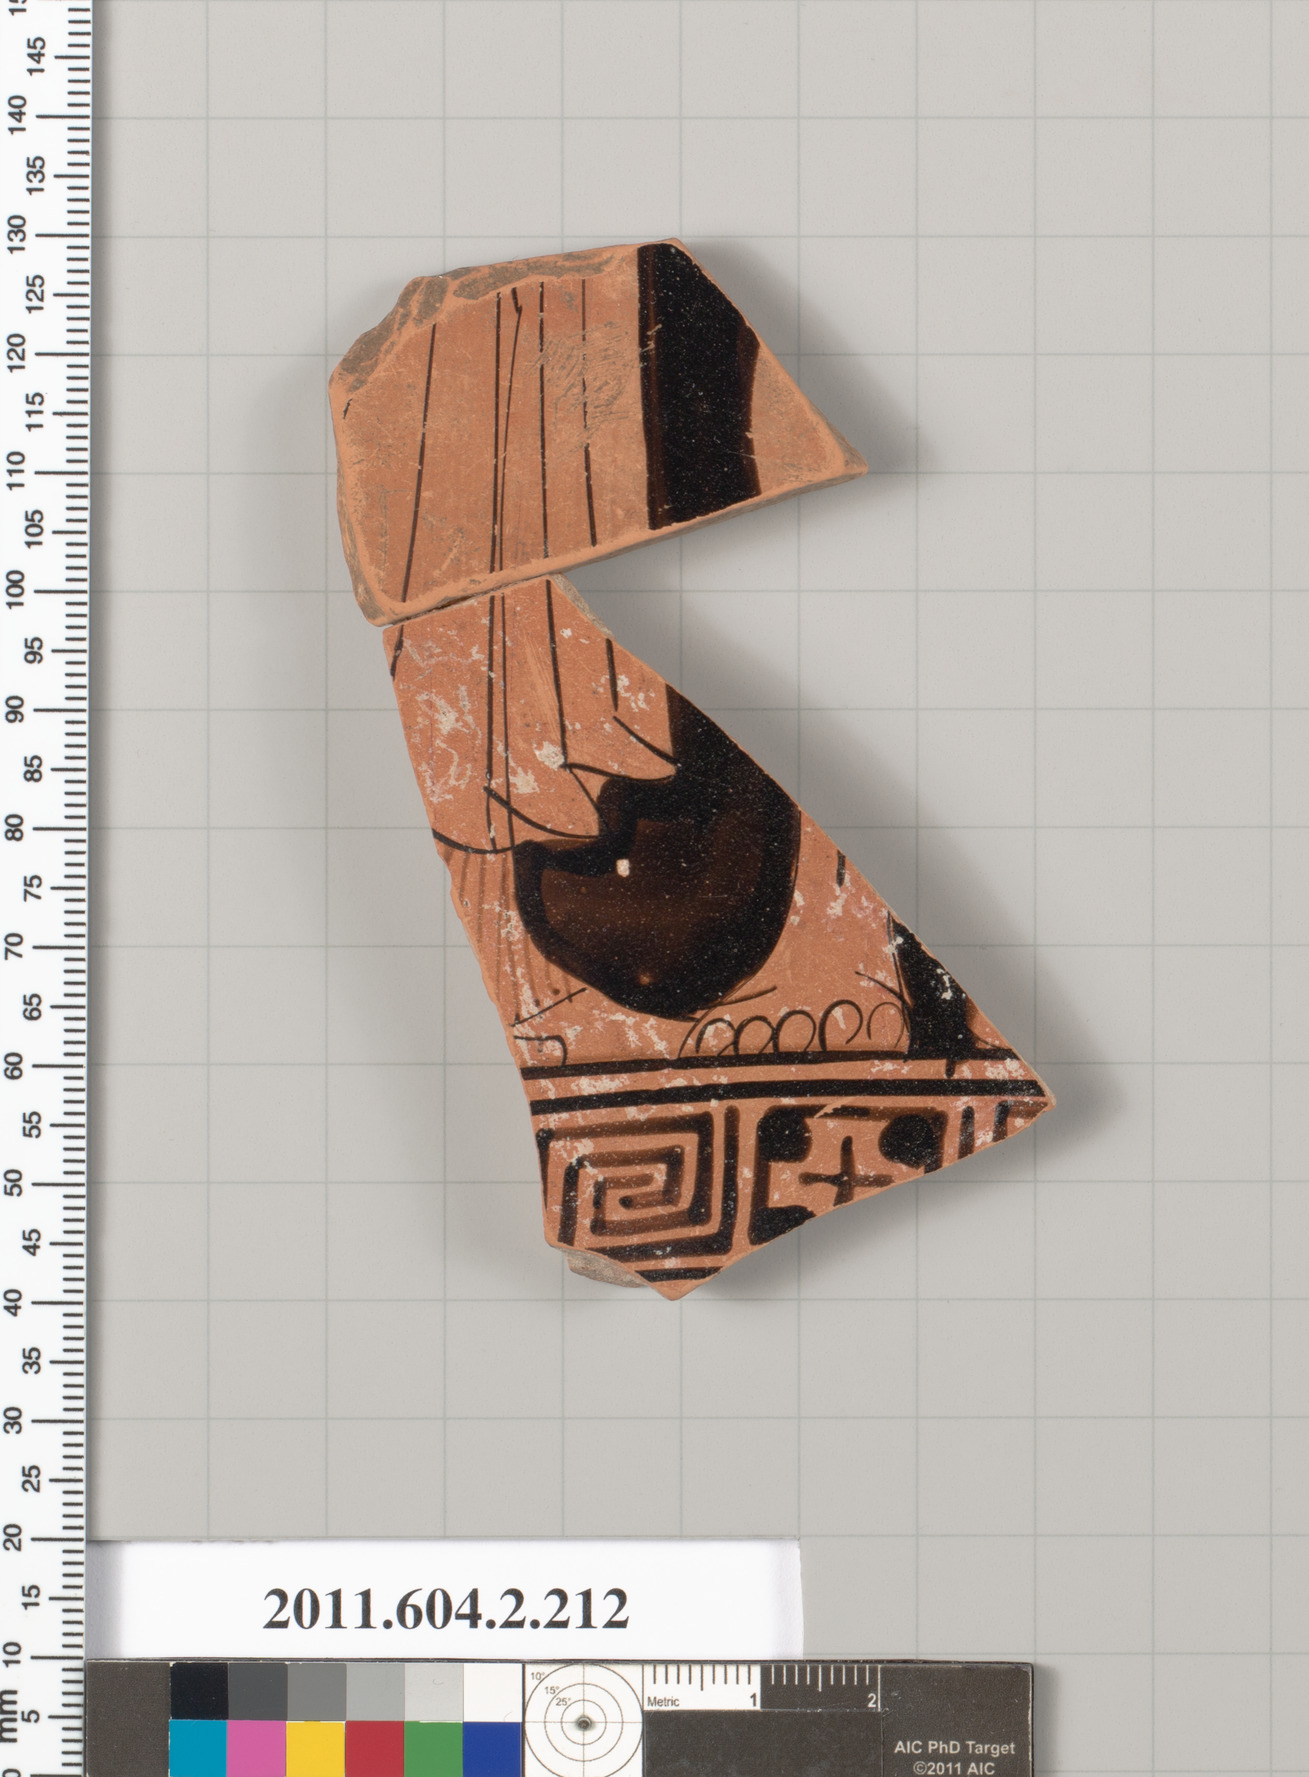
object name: stamnos fragment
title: Terracotta fragment of a stamnos (jar)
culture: greek, attic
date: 450-440 BCE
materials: terracotta